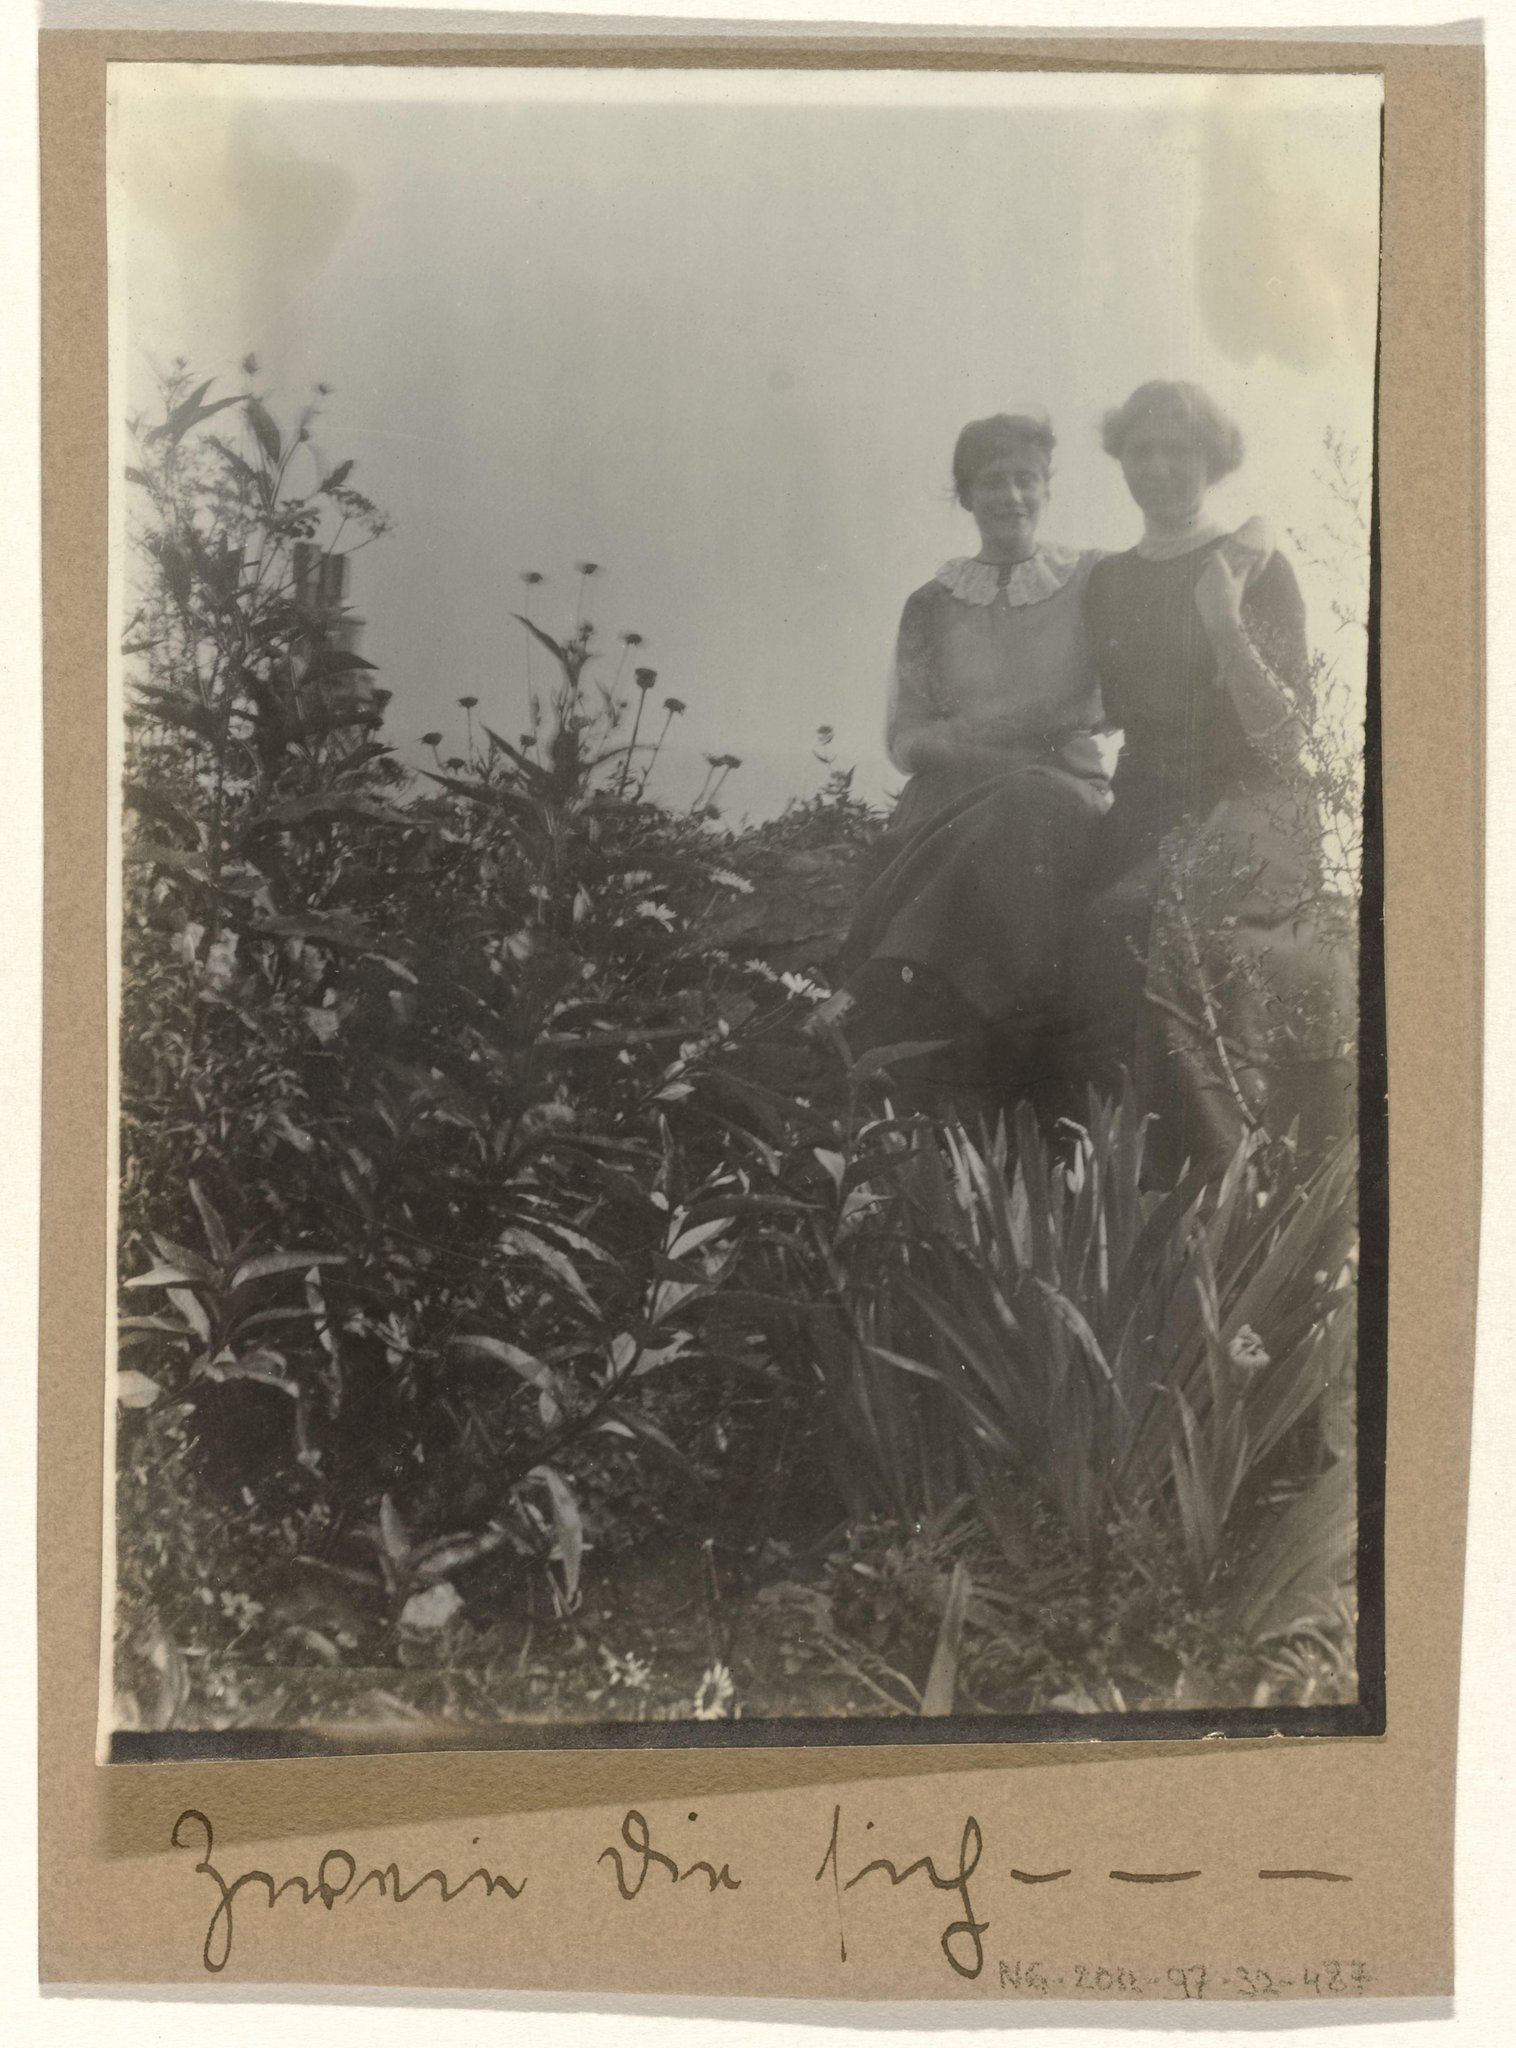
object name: photograph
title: Twee onbekende vrouwen in een landschap met hoge begroeiing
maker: Anonymous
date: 1913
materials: photographic support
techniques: gelatin silver print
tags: england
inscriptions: inscription: ‘(onleesbaar)’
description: Twee onbekende vrouwen in een landschap met hoge begroeiing.